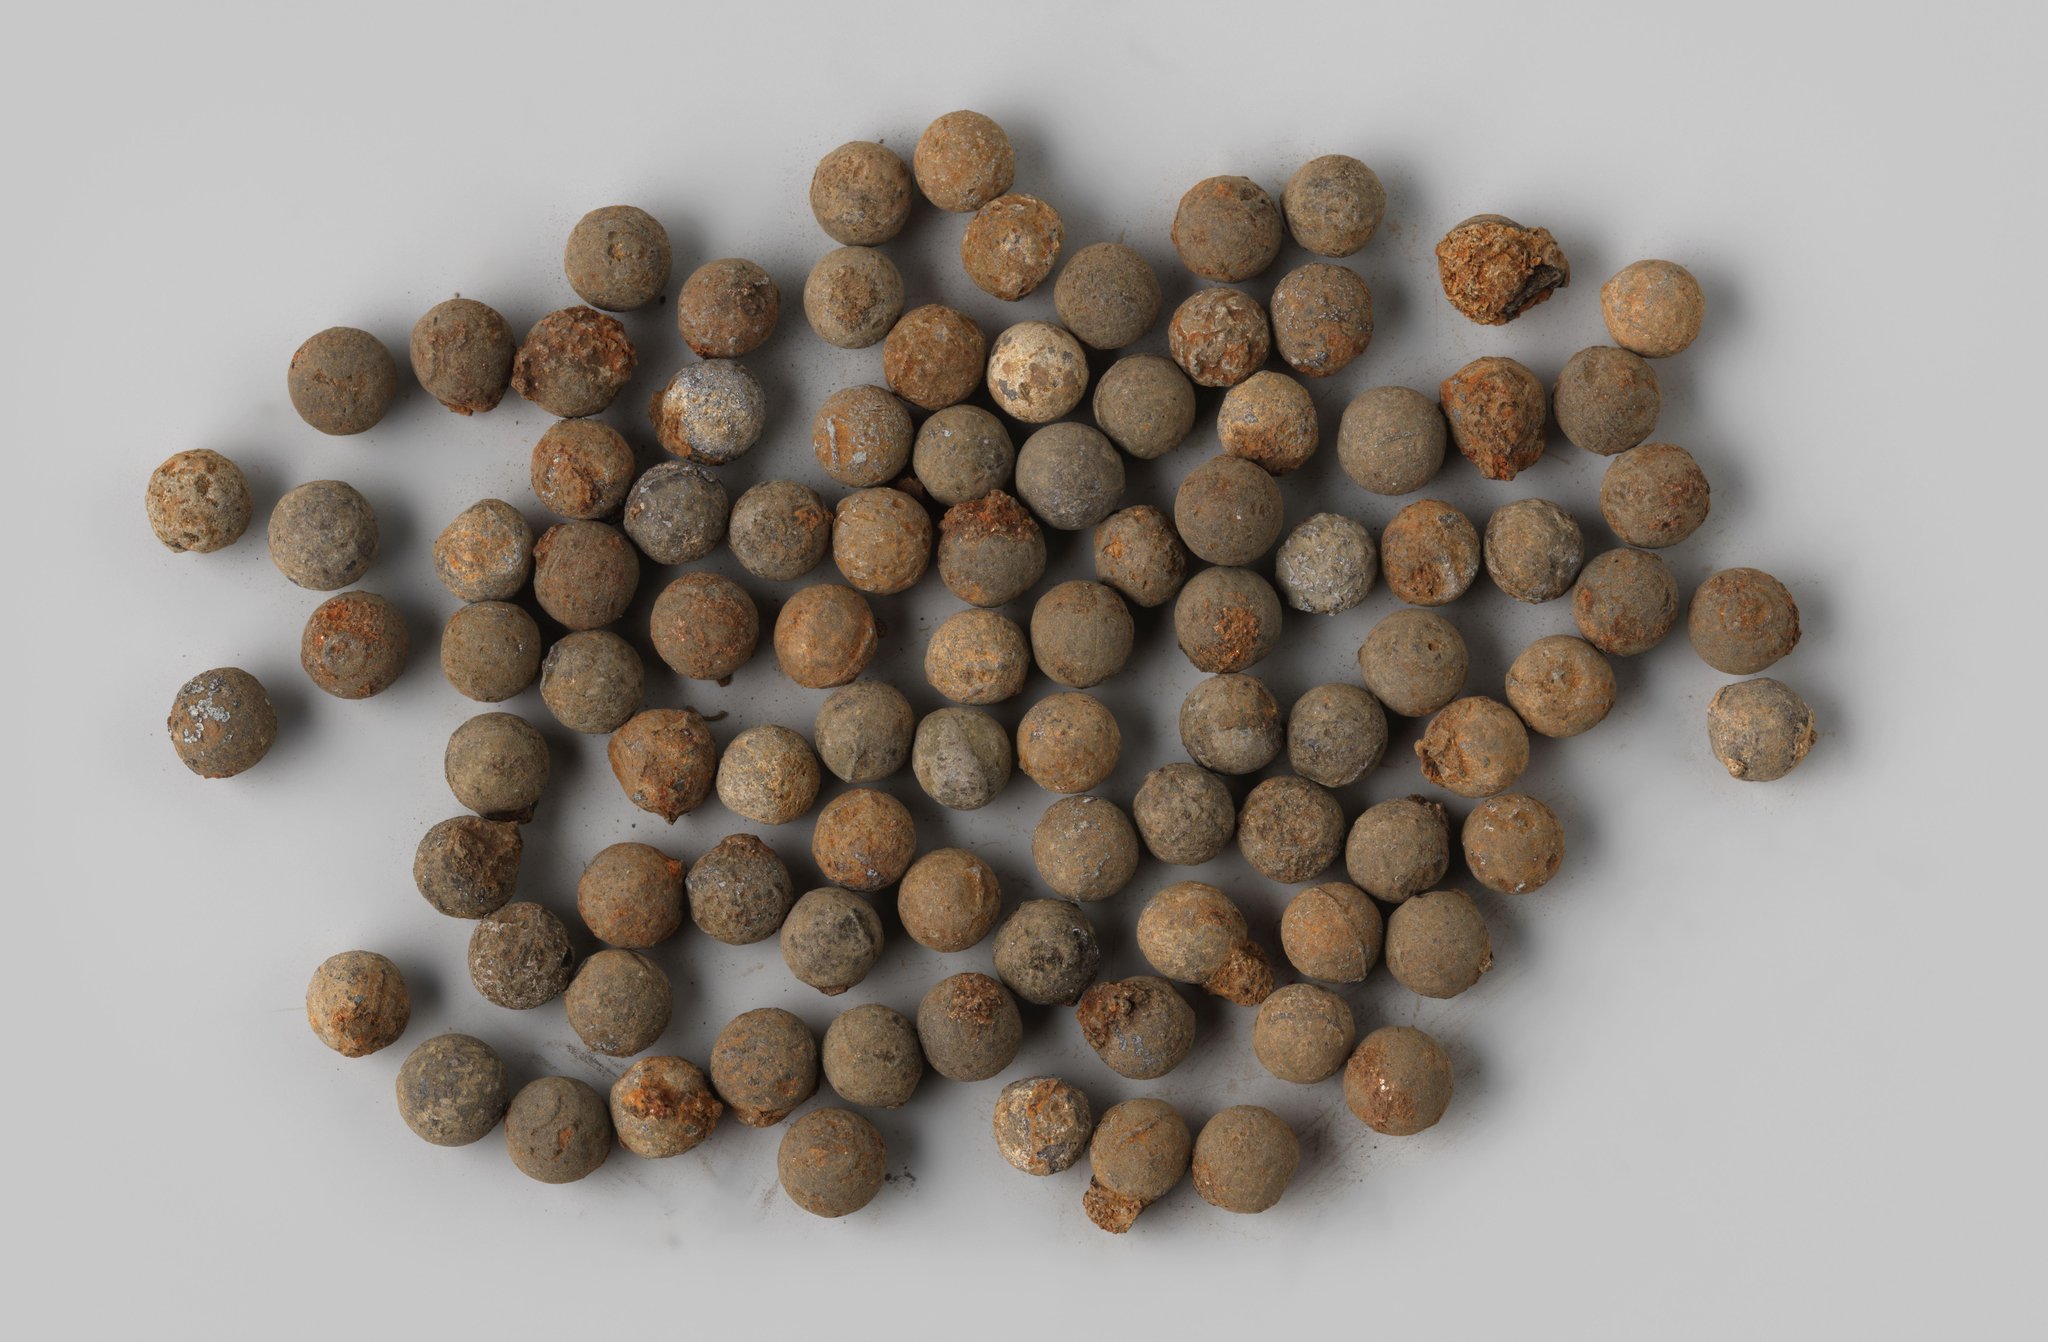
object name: bullet ammunition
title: Pistoolkogels uit het wrak van de Oost-Indiëvaarder Hollandia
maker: Anonymous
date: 1700-1743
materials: lead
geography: netherlands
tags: verenigde oostindische compagnie, hollandia (schip), annet